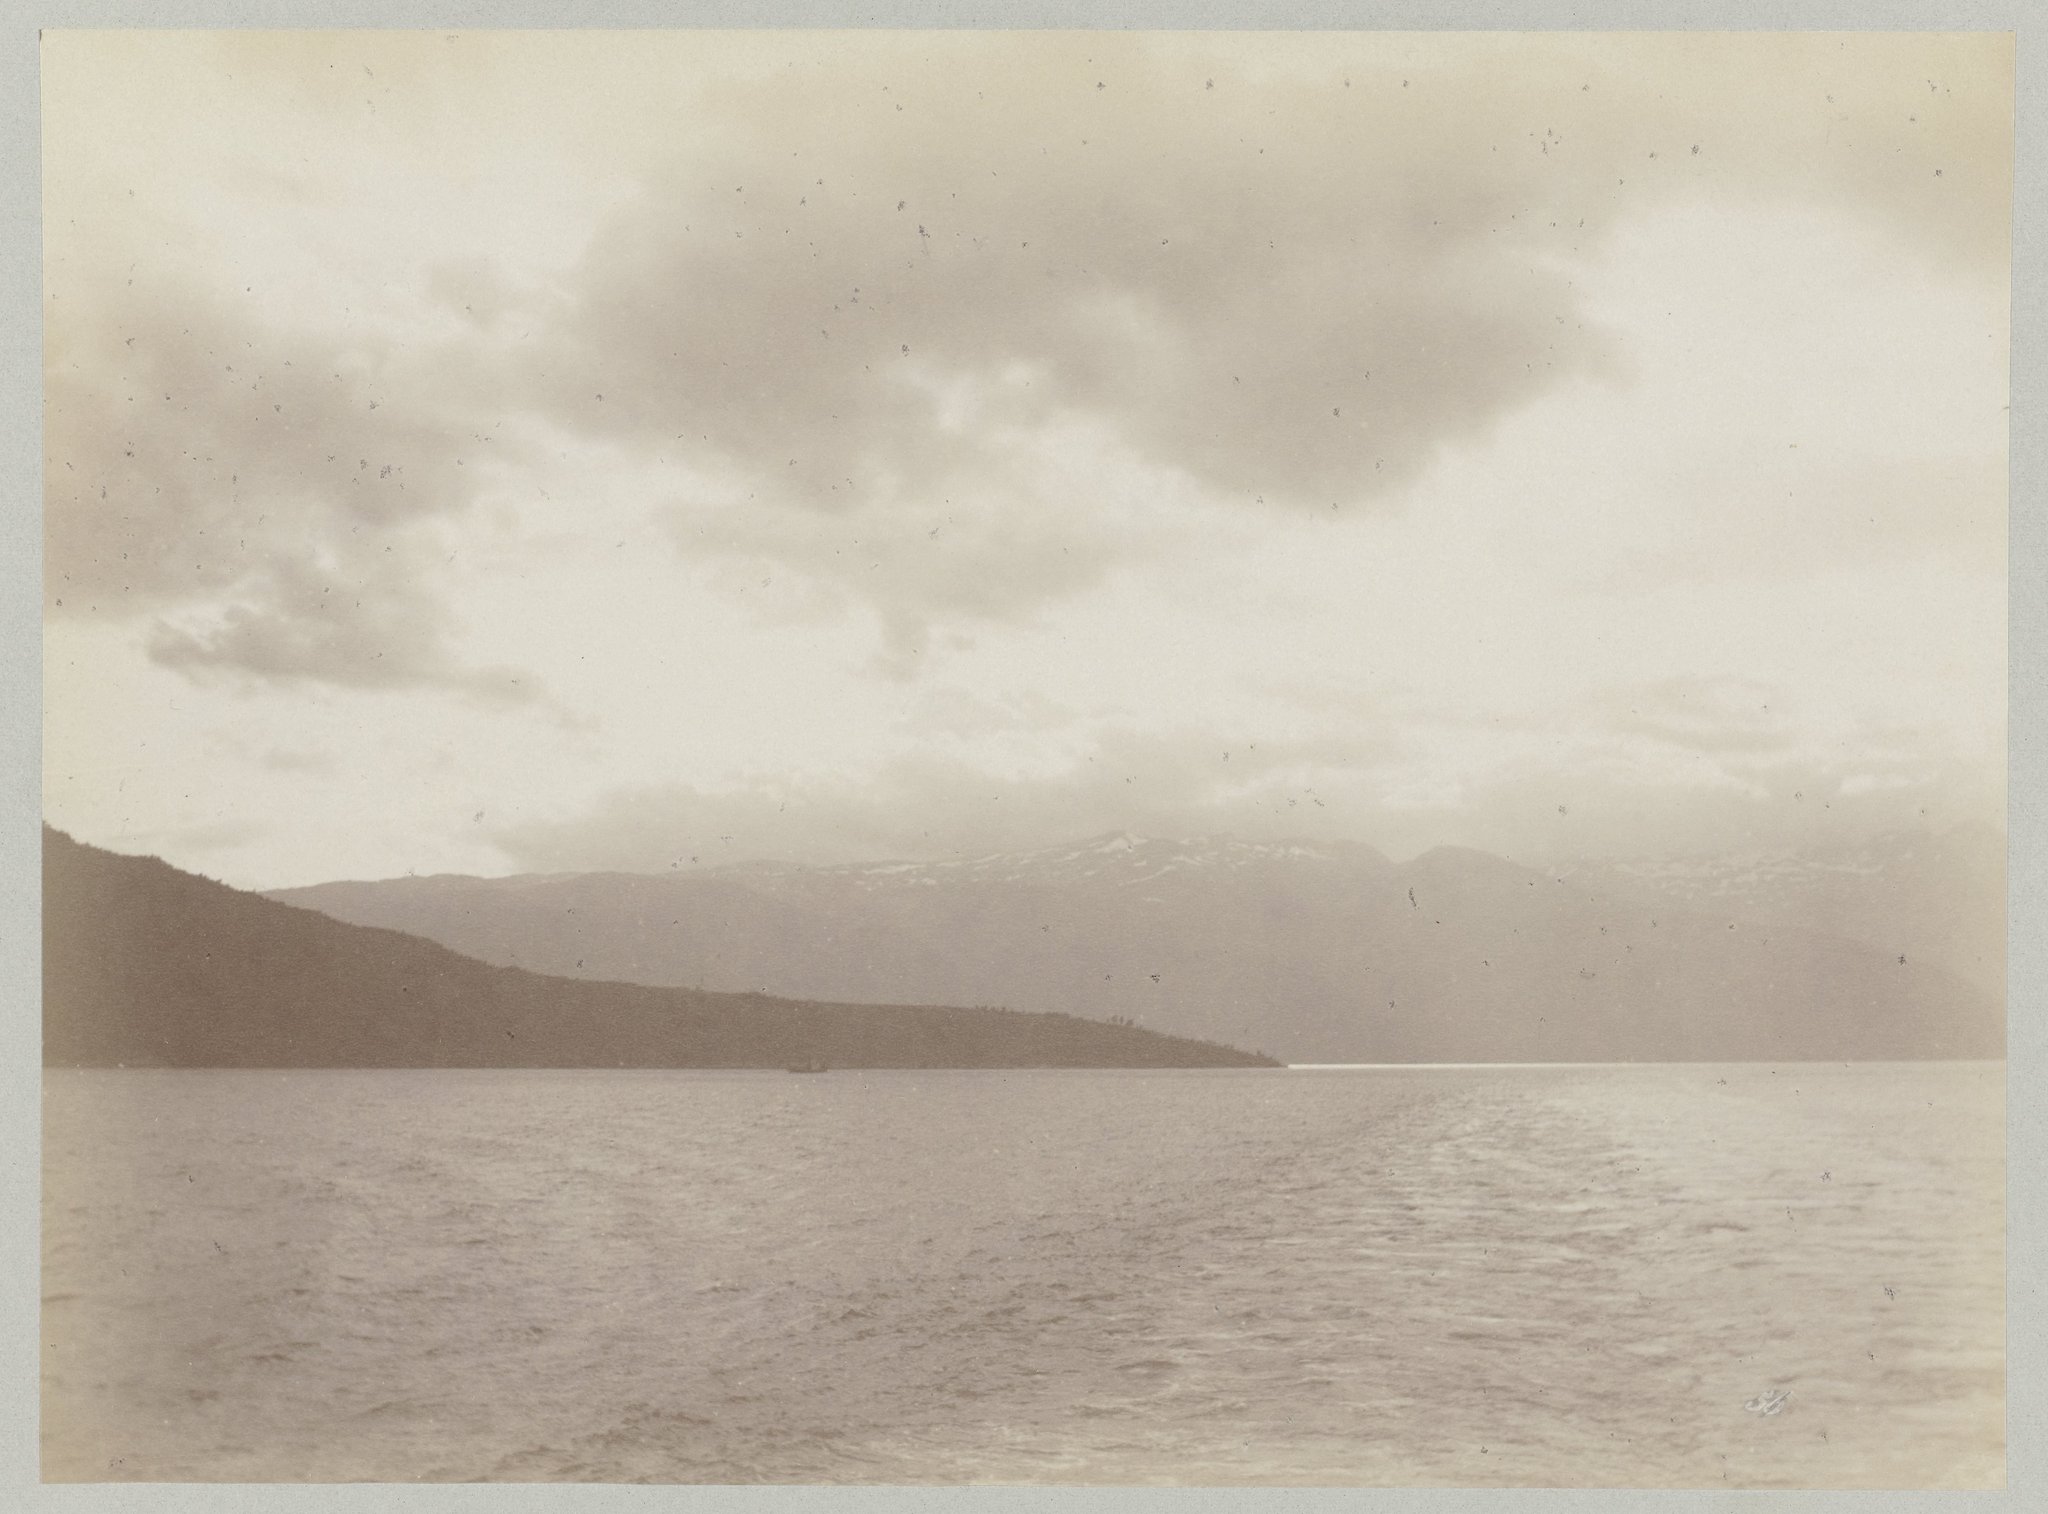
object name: photograph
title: Berg en zeegezicht in Noorwegen, gezien vanaf zee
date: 1807-1889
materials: cardboard, paper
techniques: albumen print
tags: wilhelm ii (keizer van duitsland), norway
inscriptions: number: ‘14’, number: ‘56’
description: De afdruk van de foto is rond, het papier vierkant